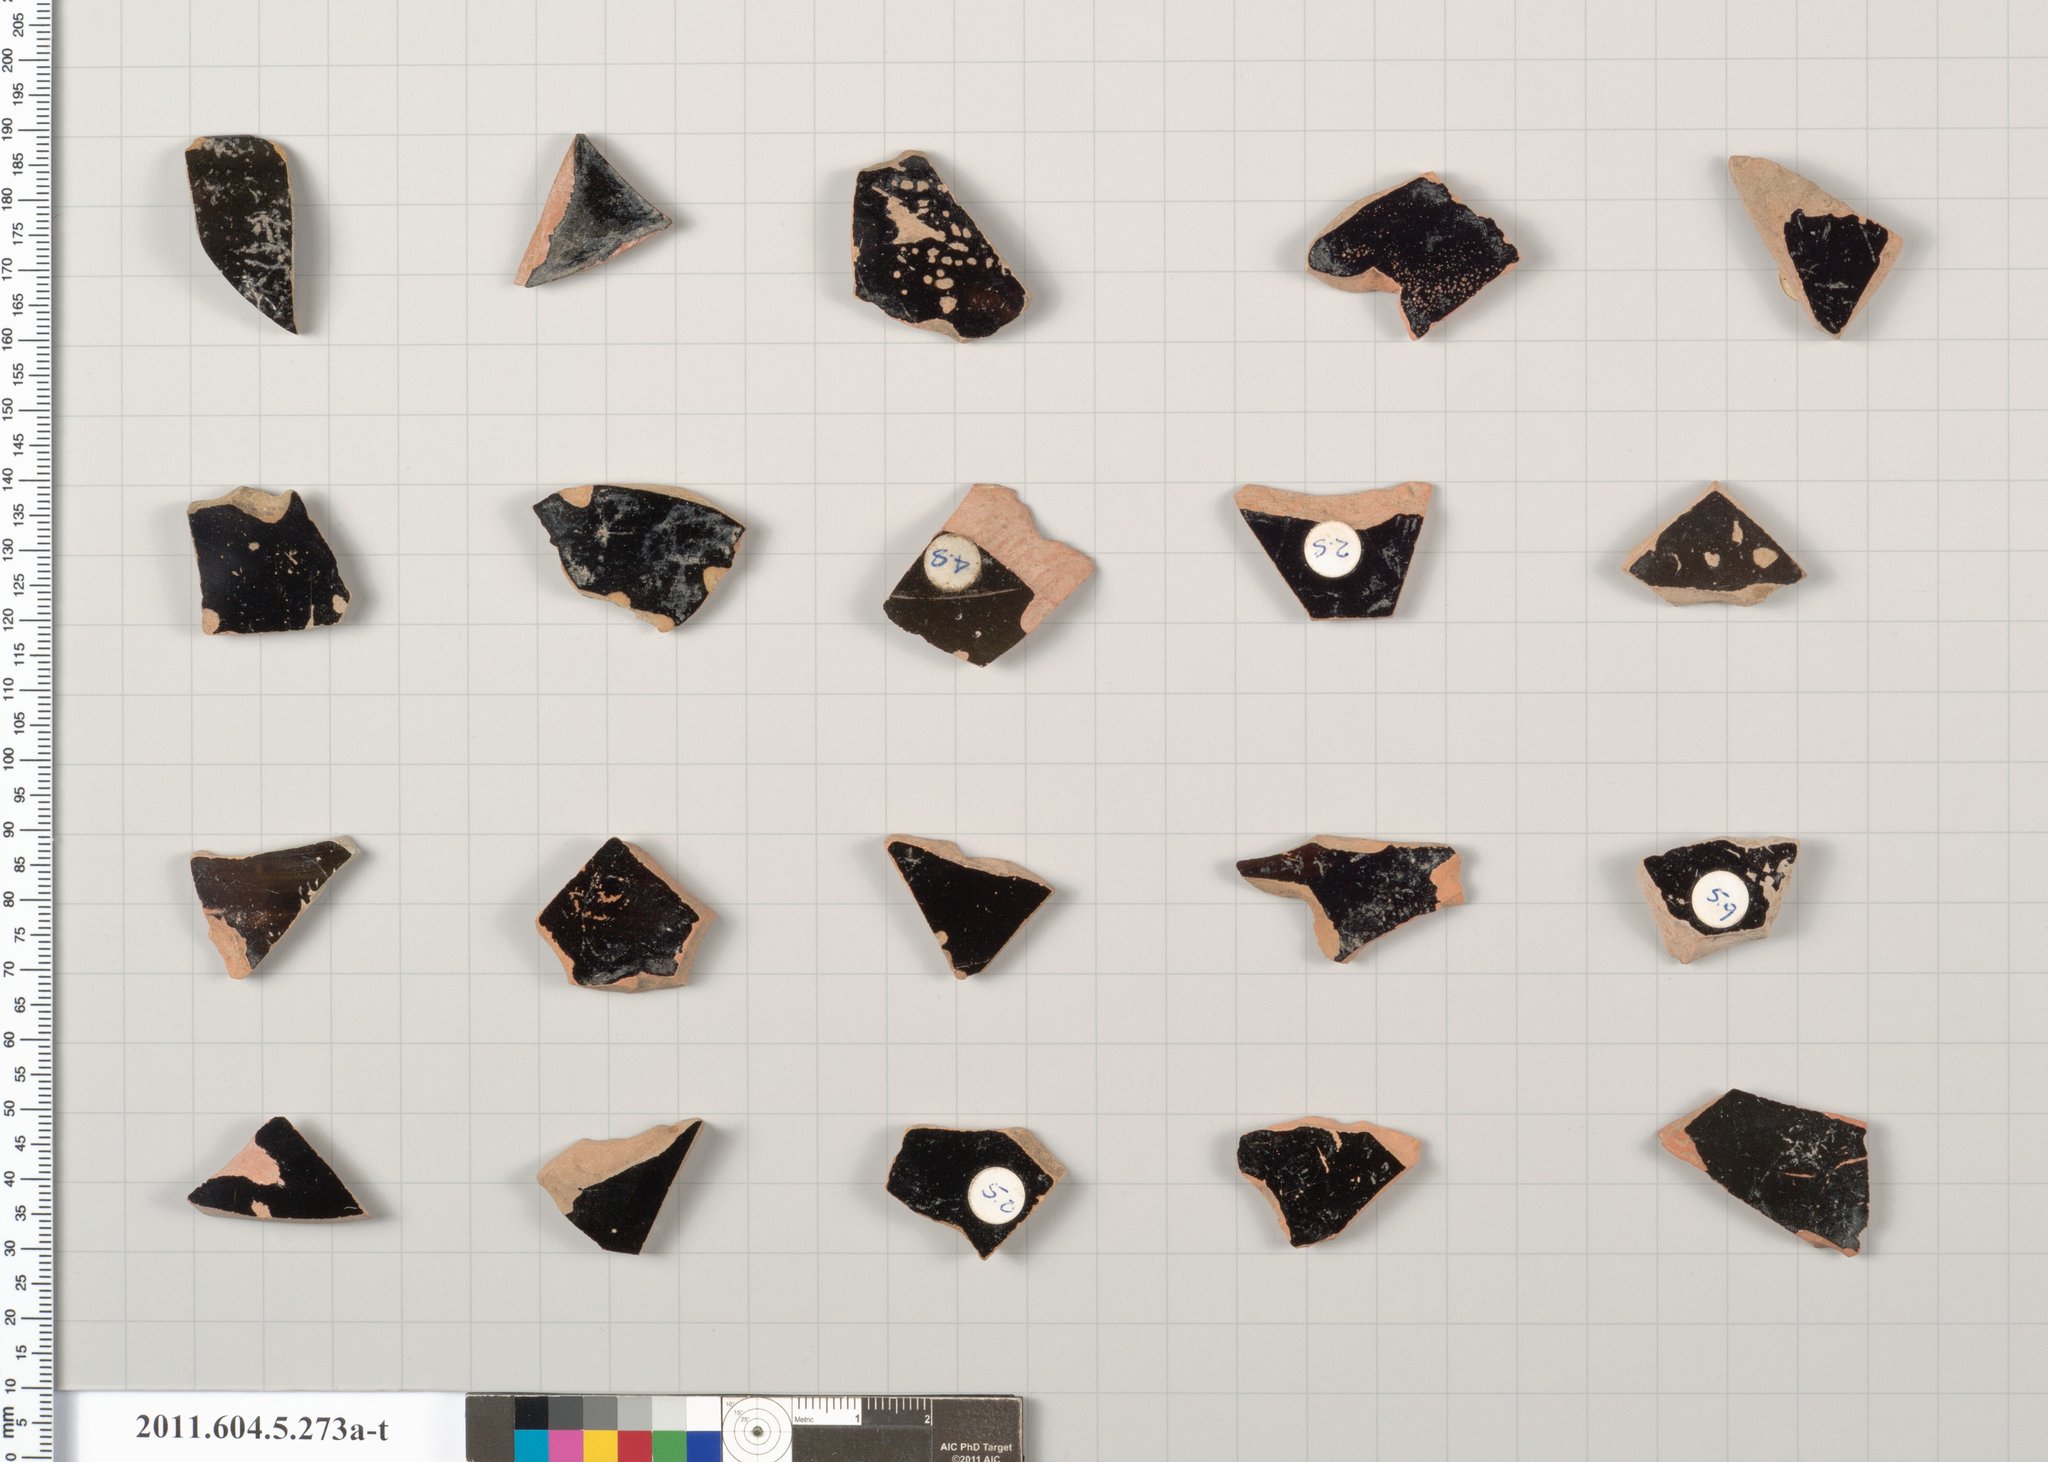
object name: kylix fragment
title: Terracotta fragments of kylikes (drinking cups)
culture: greek, attic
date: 600-401 BCE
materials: terracotta